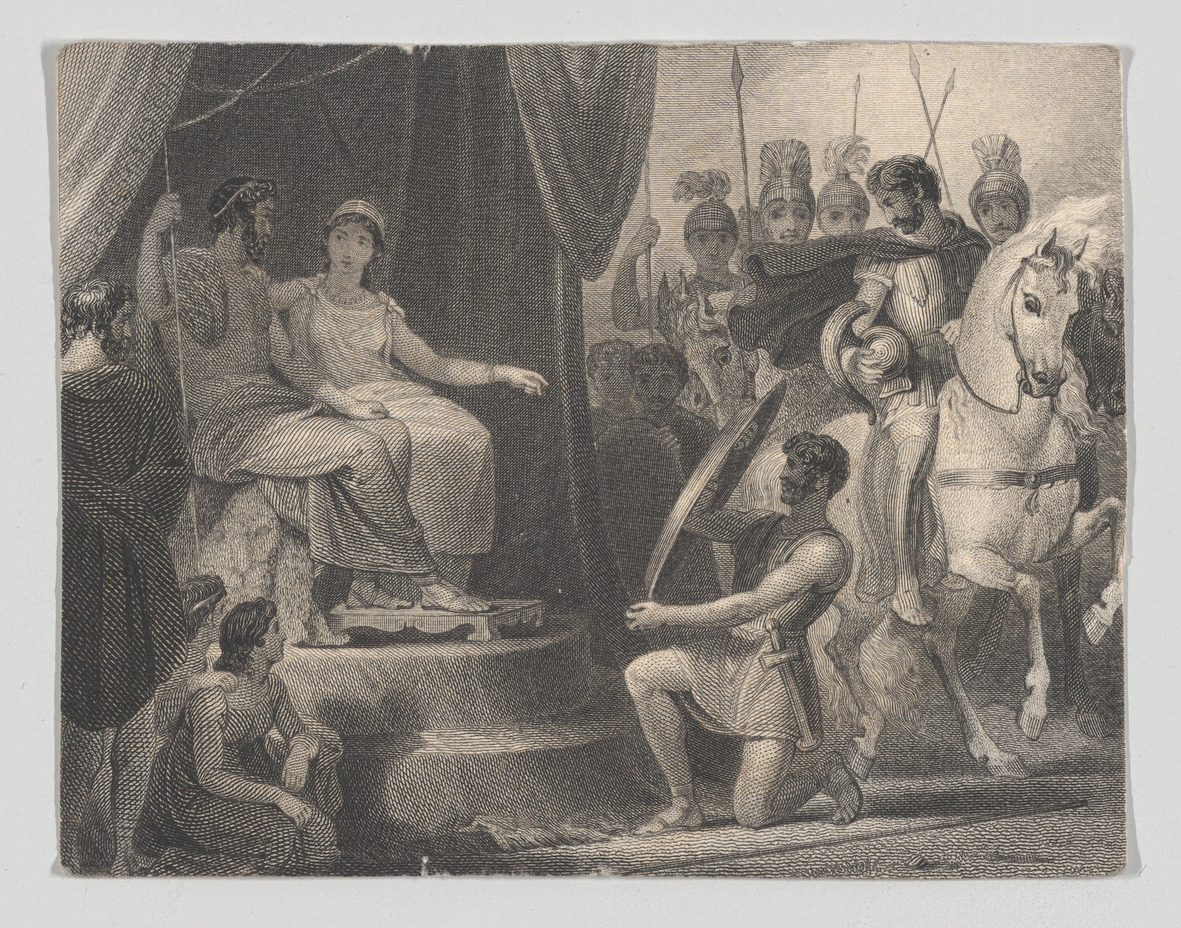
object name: print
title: Simonides and Thaisa (Shakespeare, Pericles, Act 2, Scene 2)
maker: frederick bacon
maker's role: engraver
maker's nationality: british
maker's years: 1803-1887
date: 1825-1840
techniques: engraving, etching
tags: soldiers,shields,shakespeare,men,women,horses